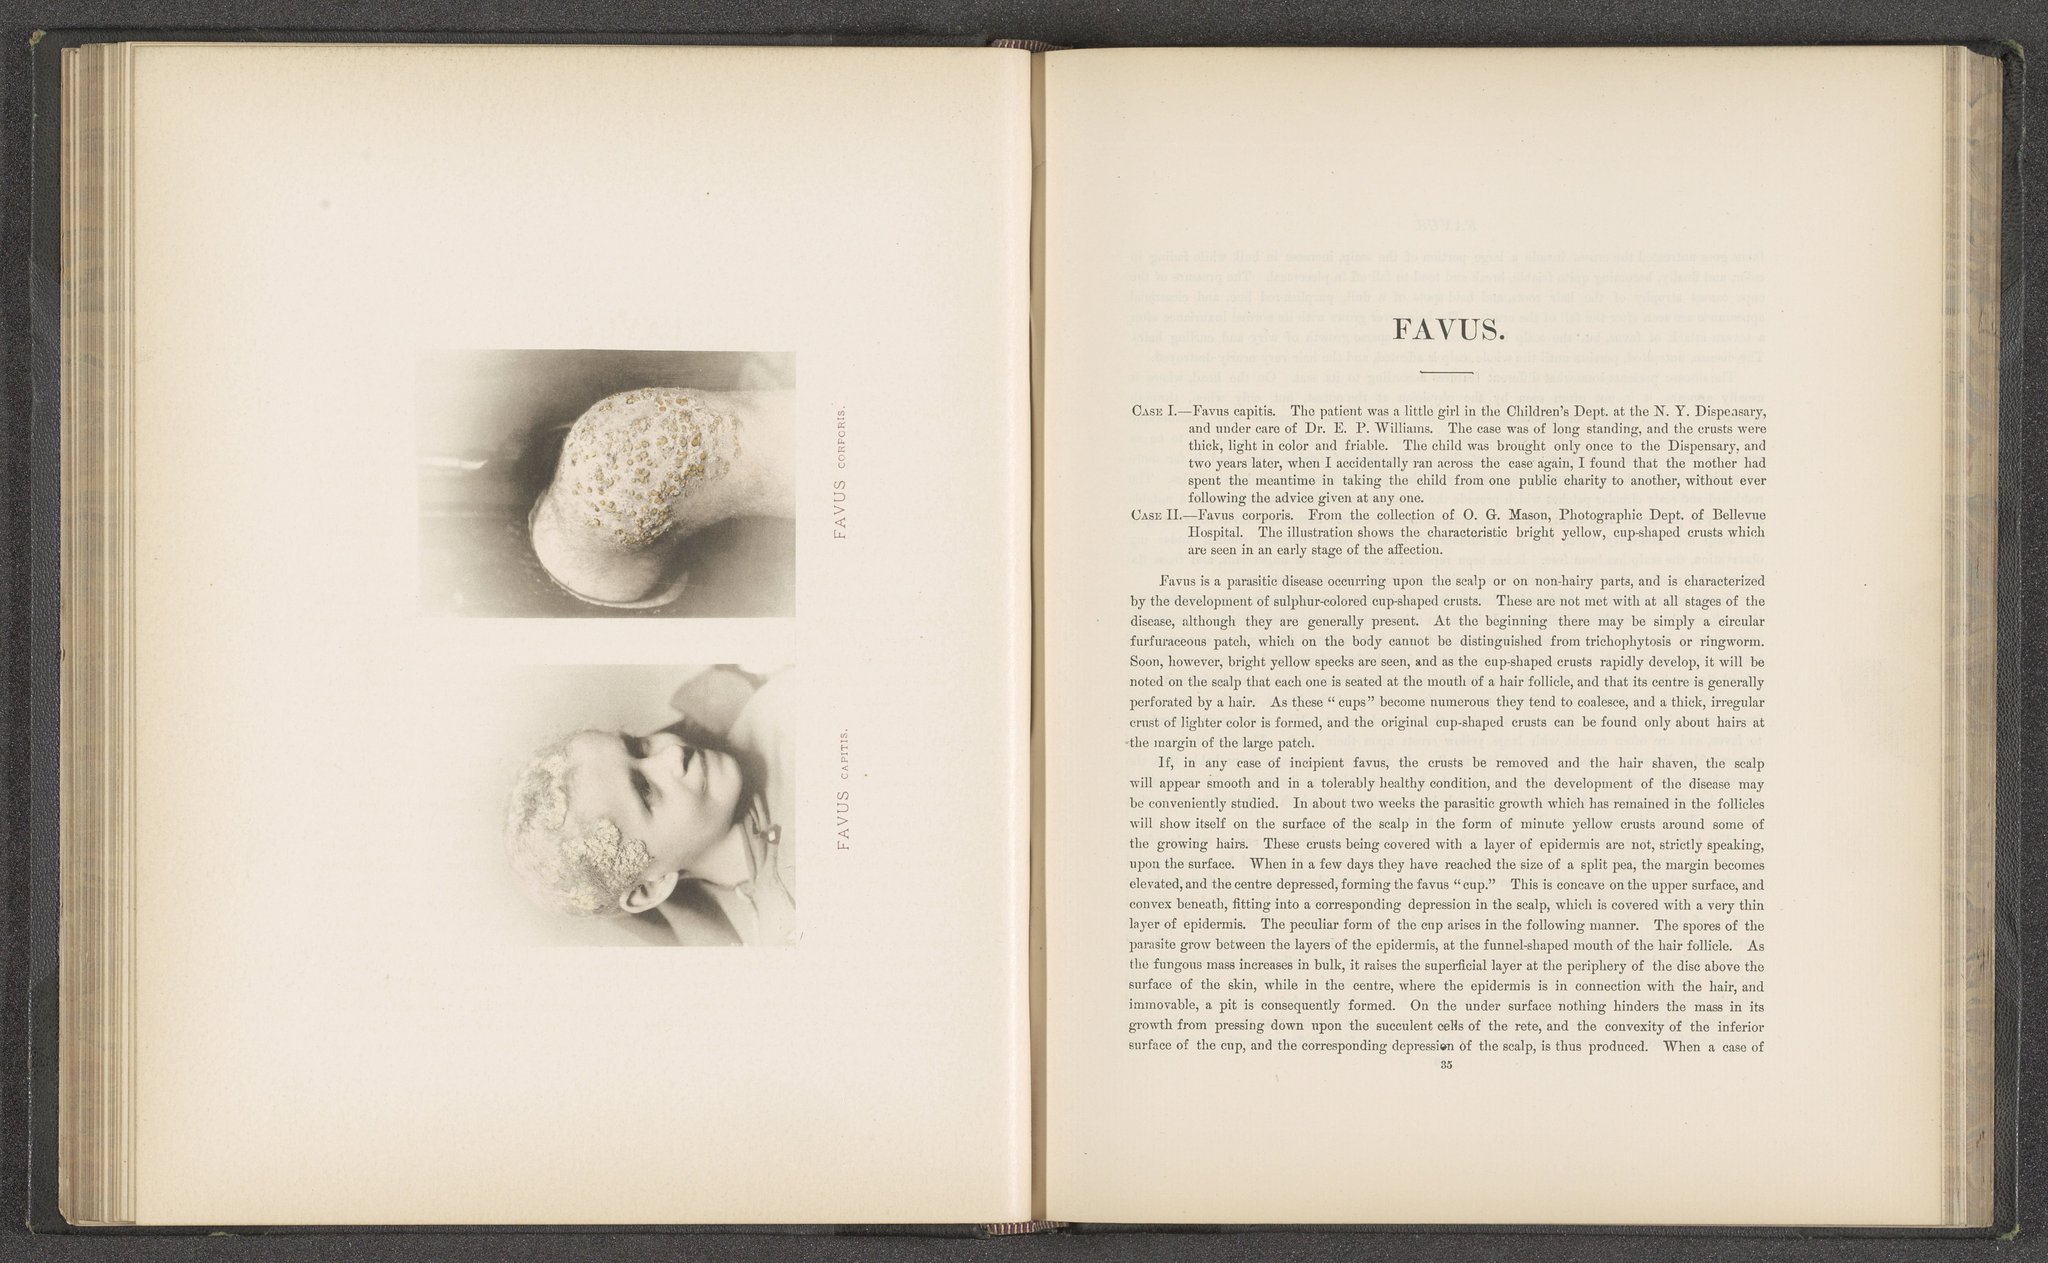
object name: photomechanical print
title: Favus corporis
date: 1870-1881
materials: paper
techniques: photograph, hand coloring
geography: new york city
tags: skin and venereal diseases, child